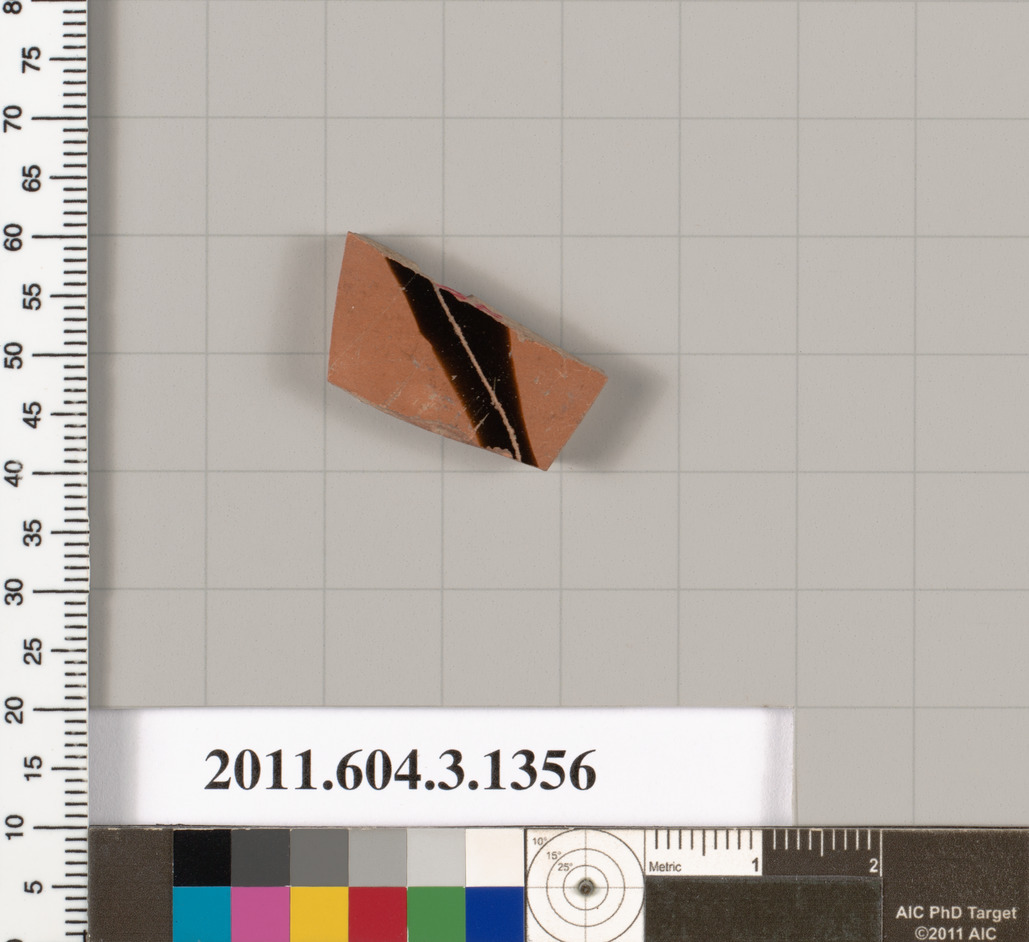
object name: skyphos fragment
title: Terracotta fragment of a skyphos (deep drinking cup)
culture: greek, attic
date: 500-468 BCE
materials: terracotta